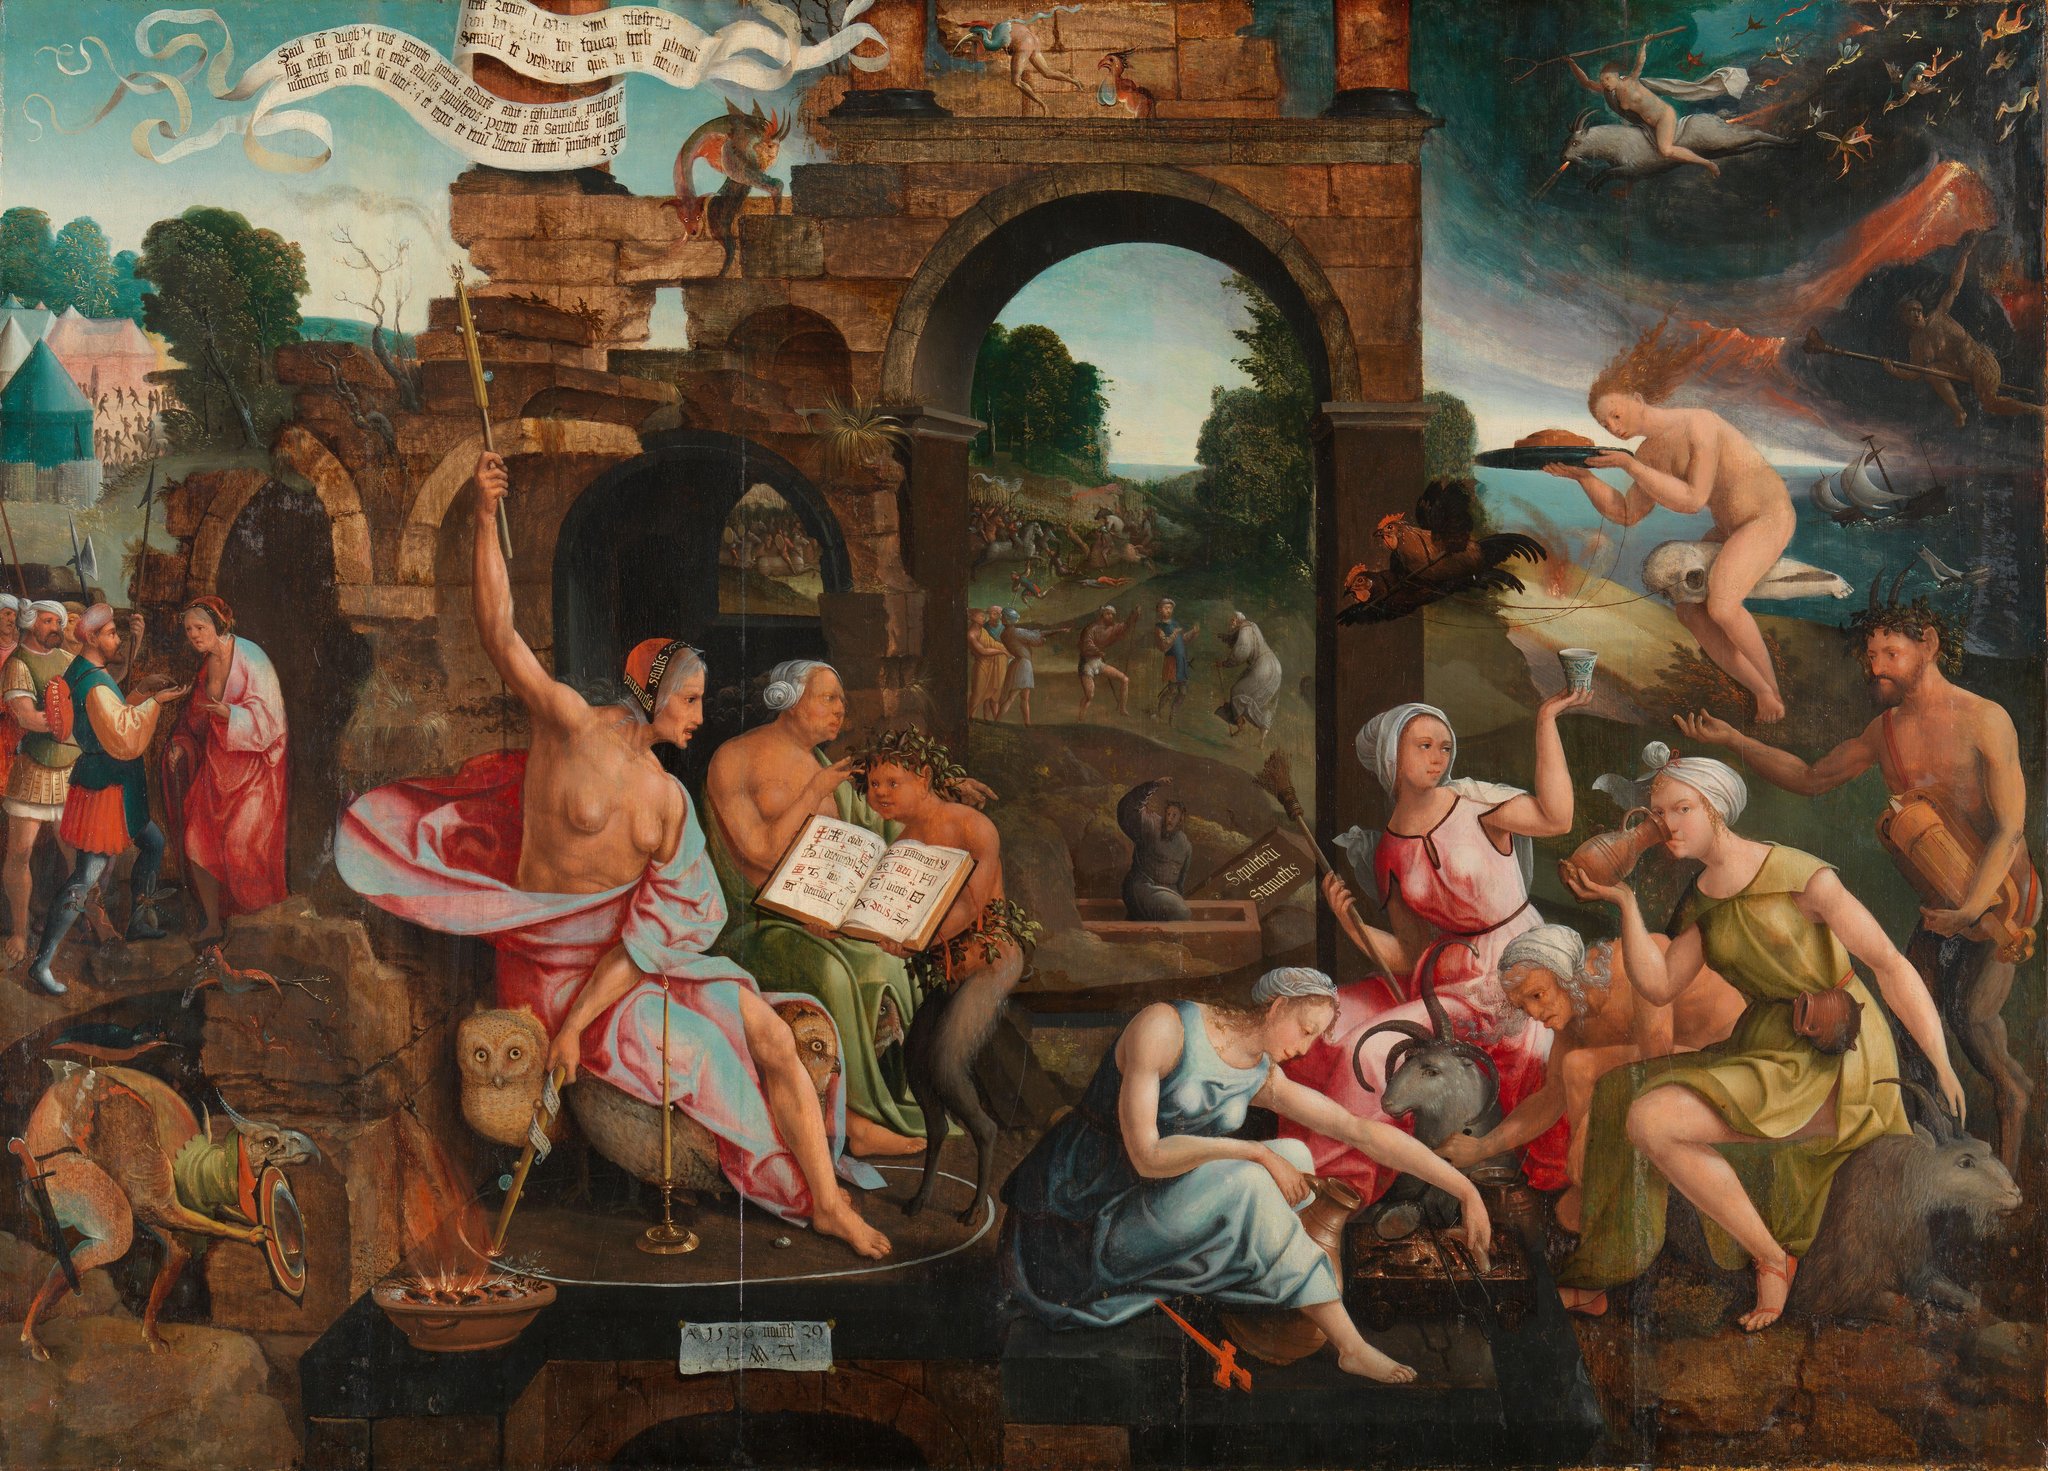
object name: painting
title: Saul and the Witch of Endor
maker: jacob cornelisz van oostsanen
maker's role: draughtsman, painter, print maker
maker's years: 1475-1533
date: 1526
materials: oil, panel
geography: amsterdam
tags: saul's death, witch(es), sorcerer(s) at work, saul with the witch of endor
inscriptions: signature and date, lower centre on a cartellino: ‘Aº 1526 noveb. 29 // I. A.’, signature, upper left, on a banderole: ‘leest Regum j[...] ghescreven // [...] Saul tot tovery heeft gehev.. // Samuel te verwrecke qua. hij te sne.ven’, signature, upper left, on a banderole: ‘Saul cu[m] duob [v]iris ignoto habitum endorem adit:[...] consulturus pythonem // sup evetu[...] belli Q [...] ei erat adusus philisteos [...]Porro aia [...] Samuelis iussu // numinis ad colloqium [?] elicit r [?] q [?] et regis et triu [?] liberou iteritu [?] pnutiat [?] i regu [...] // 28’, signature, on Samuel’s gravestone: ‘Sepulchu[.] // Samuelis’, signature, on the witch’s cap: ‘pitonissa // Saulis’, signature, on the albarello: ‘MAL (Evil)’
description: Fearing the outcome of a battle, Saul, king of the Israelites, consulted the fortune-telling witch of Endor. The prophecy came true: Saul lost the battle, but shortly before he was to be killed, he threw himself on his sword. His suicide – in the middle background – is a warning against witchcraft. In the foreground is a Witches’ Sabbath: the fortune-teller sits within a chalk circle, surrounded by other witches, satyrs, and imaginary figures.